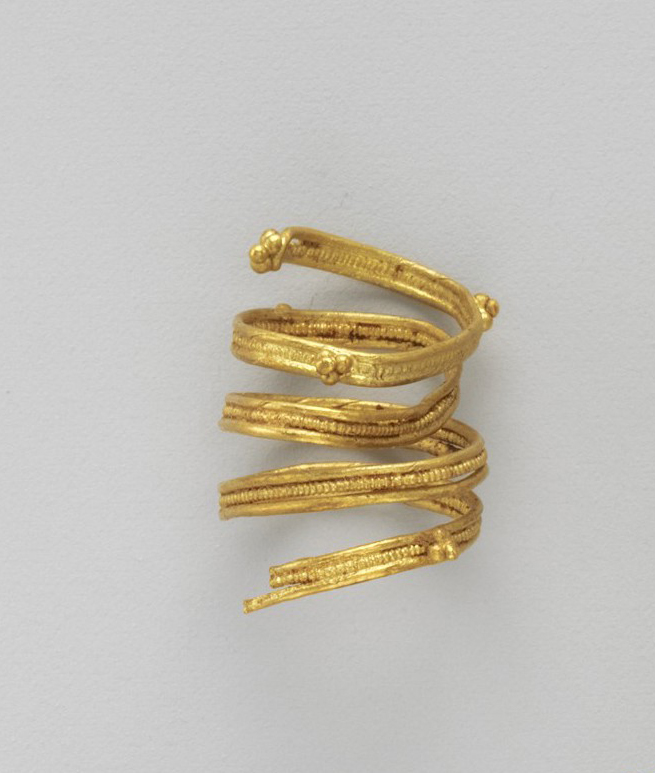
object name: spiral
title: Gold spiral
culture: etruscan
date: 700-501 BCE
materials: gold